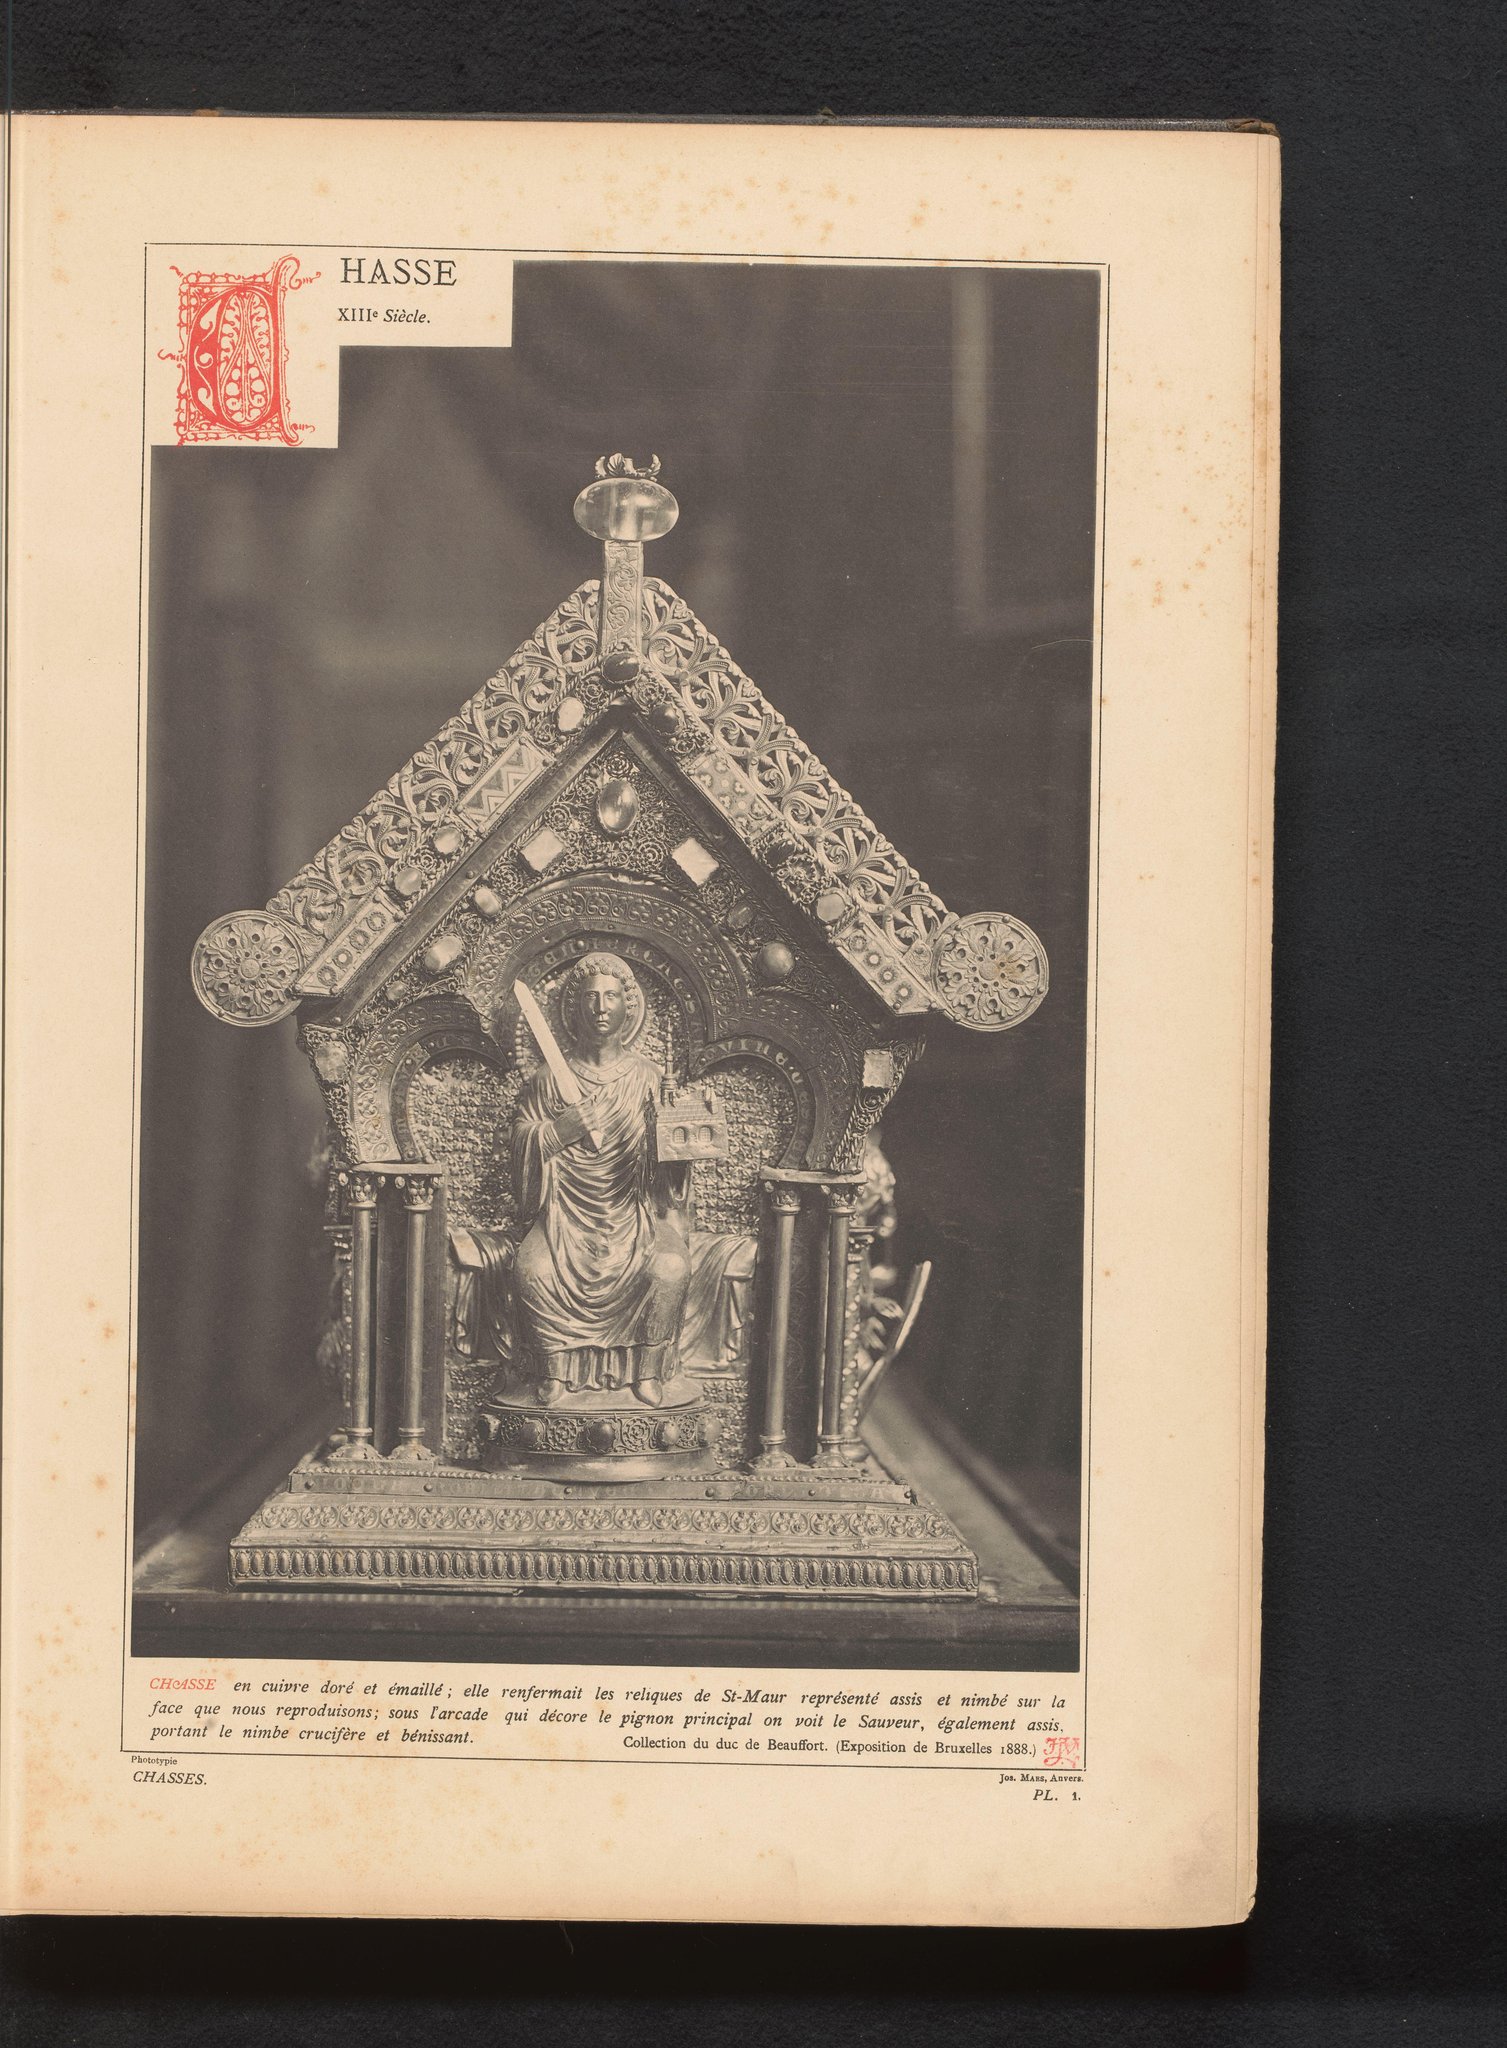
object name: page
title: Chasse, XIIIe Siècle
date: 1881-1889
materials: paper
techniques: photograph, photolithography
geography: antwerp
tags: relics (and reliquaries)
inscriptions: monogram: ‘JJvY’, inscription: ‘CHASSE en cuivre (...)’, inscription: ‘CHASSES. PL.1.’